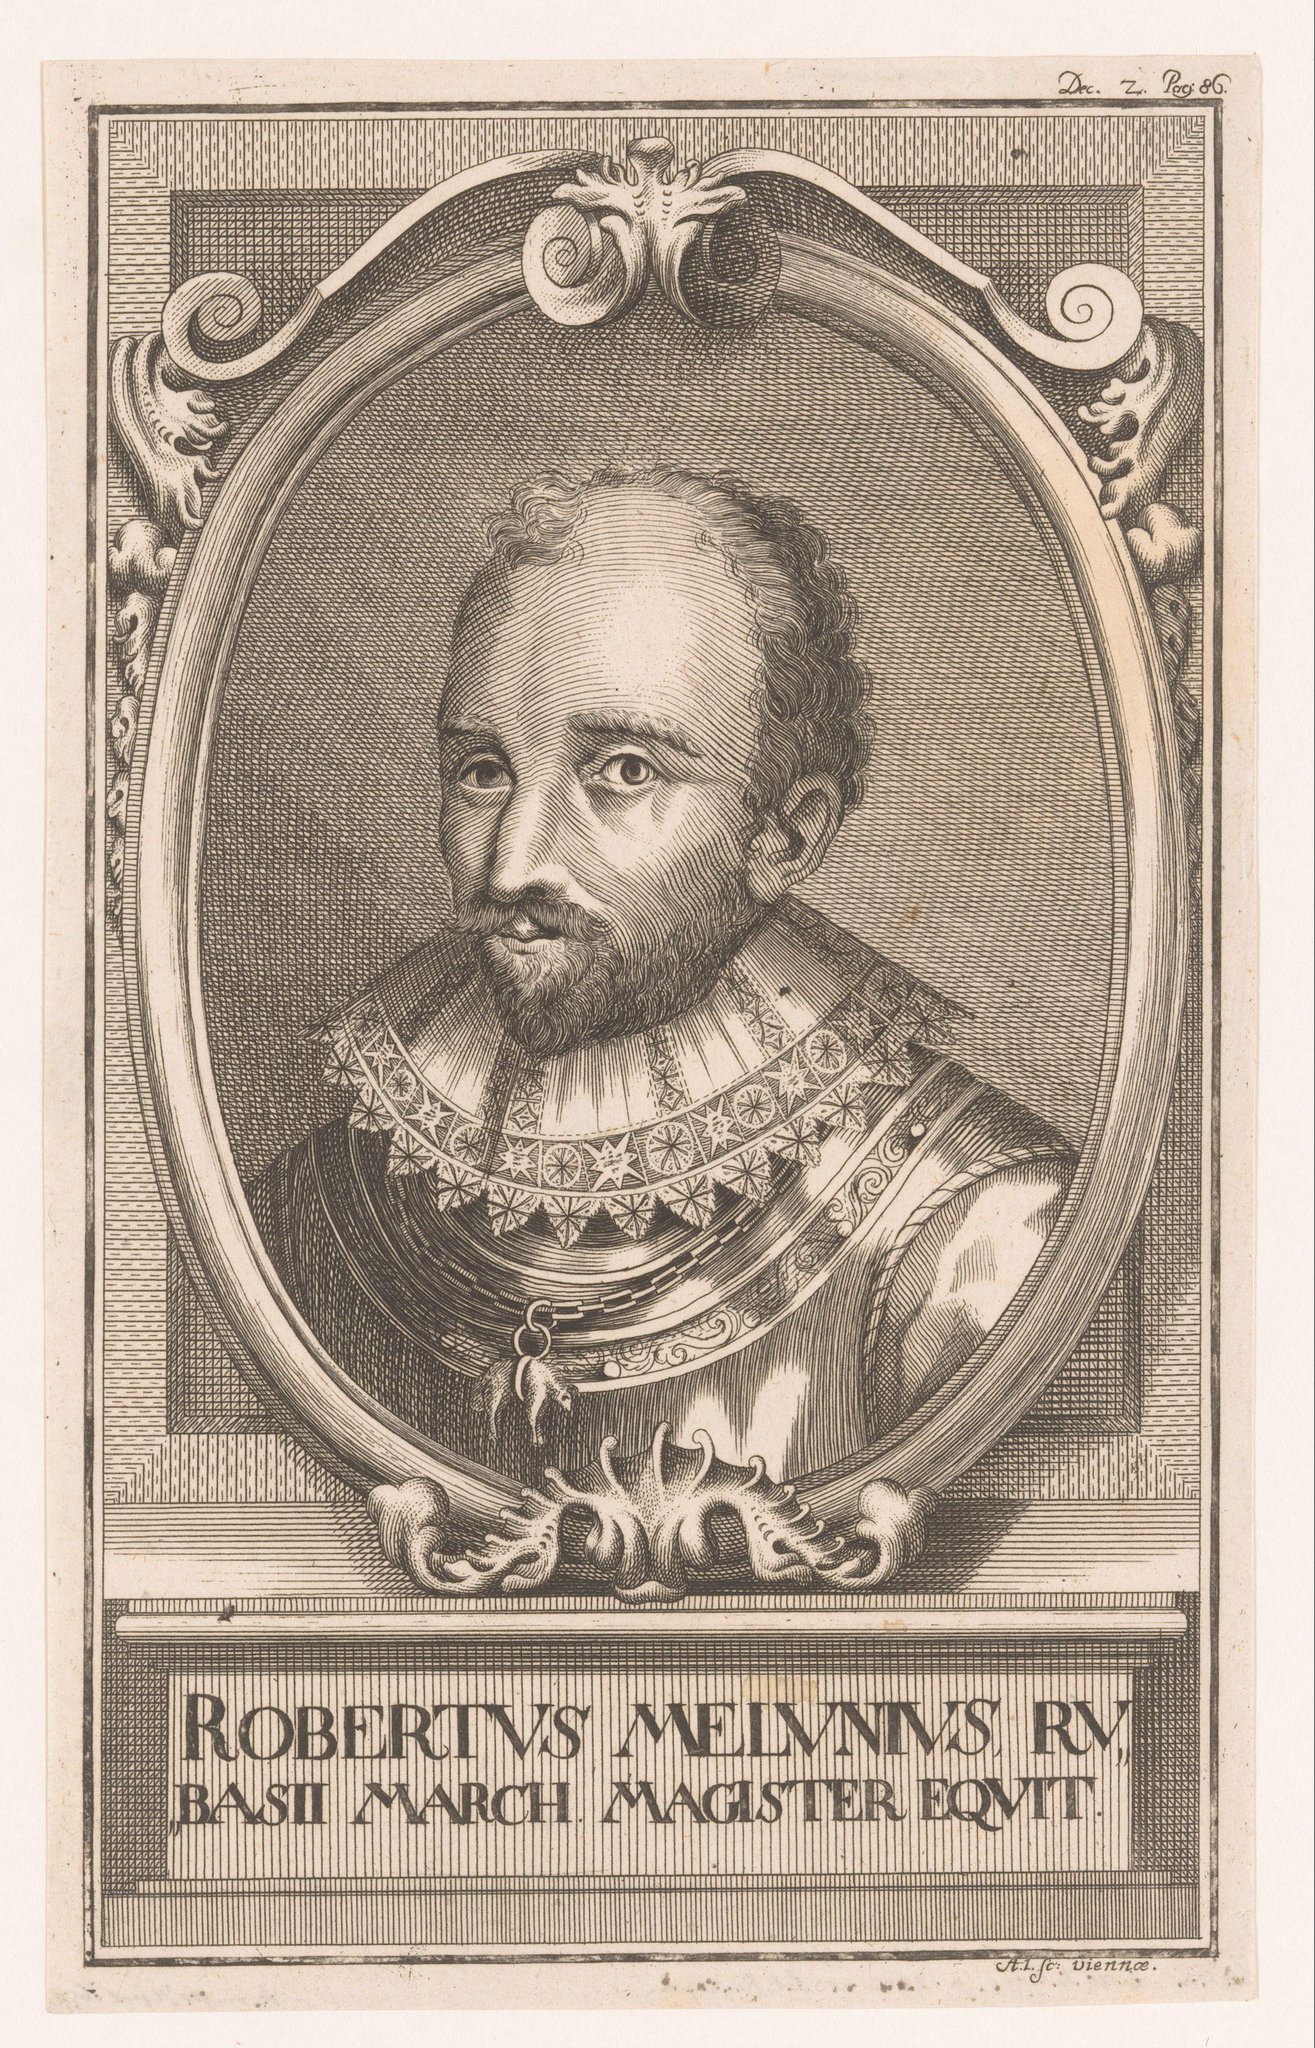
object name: print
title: Portret van Robert van Melun, markies van Roubaix, burggraaf van Gent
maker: monogrammist al (18e eeuw)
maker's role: print maker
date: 1754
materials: paper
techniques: engraving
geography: vienna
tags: historical persons, knighthood order of the golden fleece - insignia of a knighthood order, e.g.: badge, chain (with name of order)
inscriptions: collector's mark: Lugt 2228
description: Prent ook gebruikt in: Strada, Famiano: De Bello Belgico (...) Editio novissima. Regensburg/Wenen: Emmerich Felix Bader, 1754.